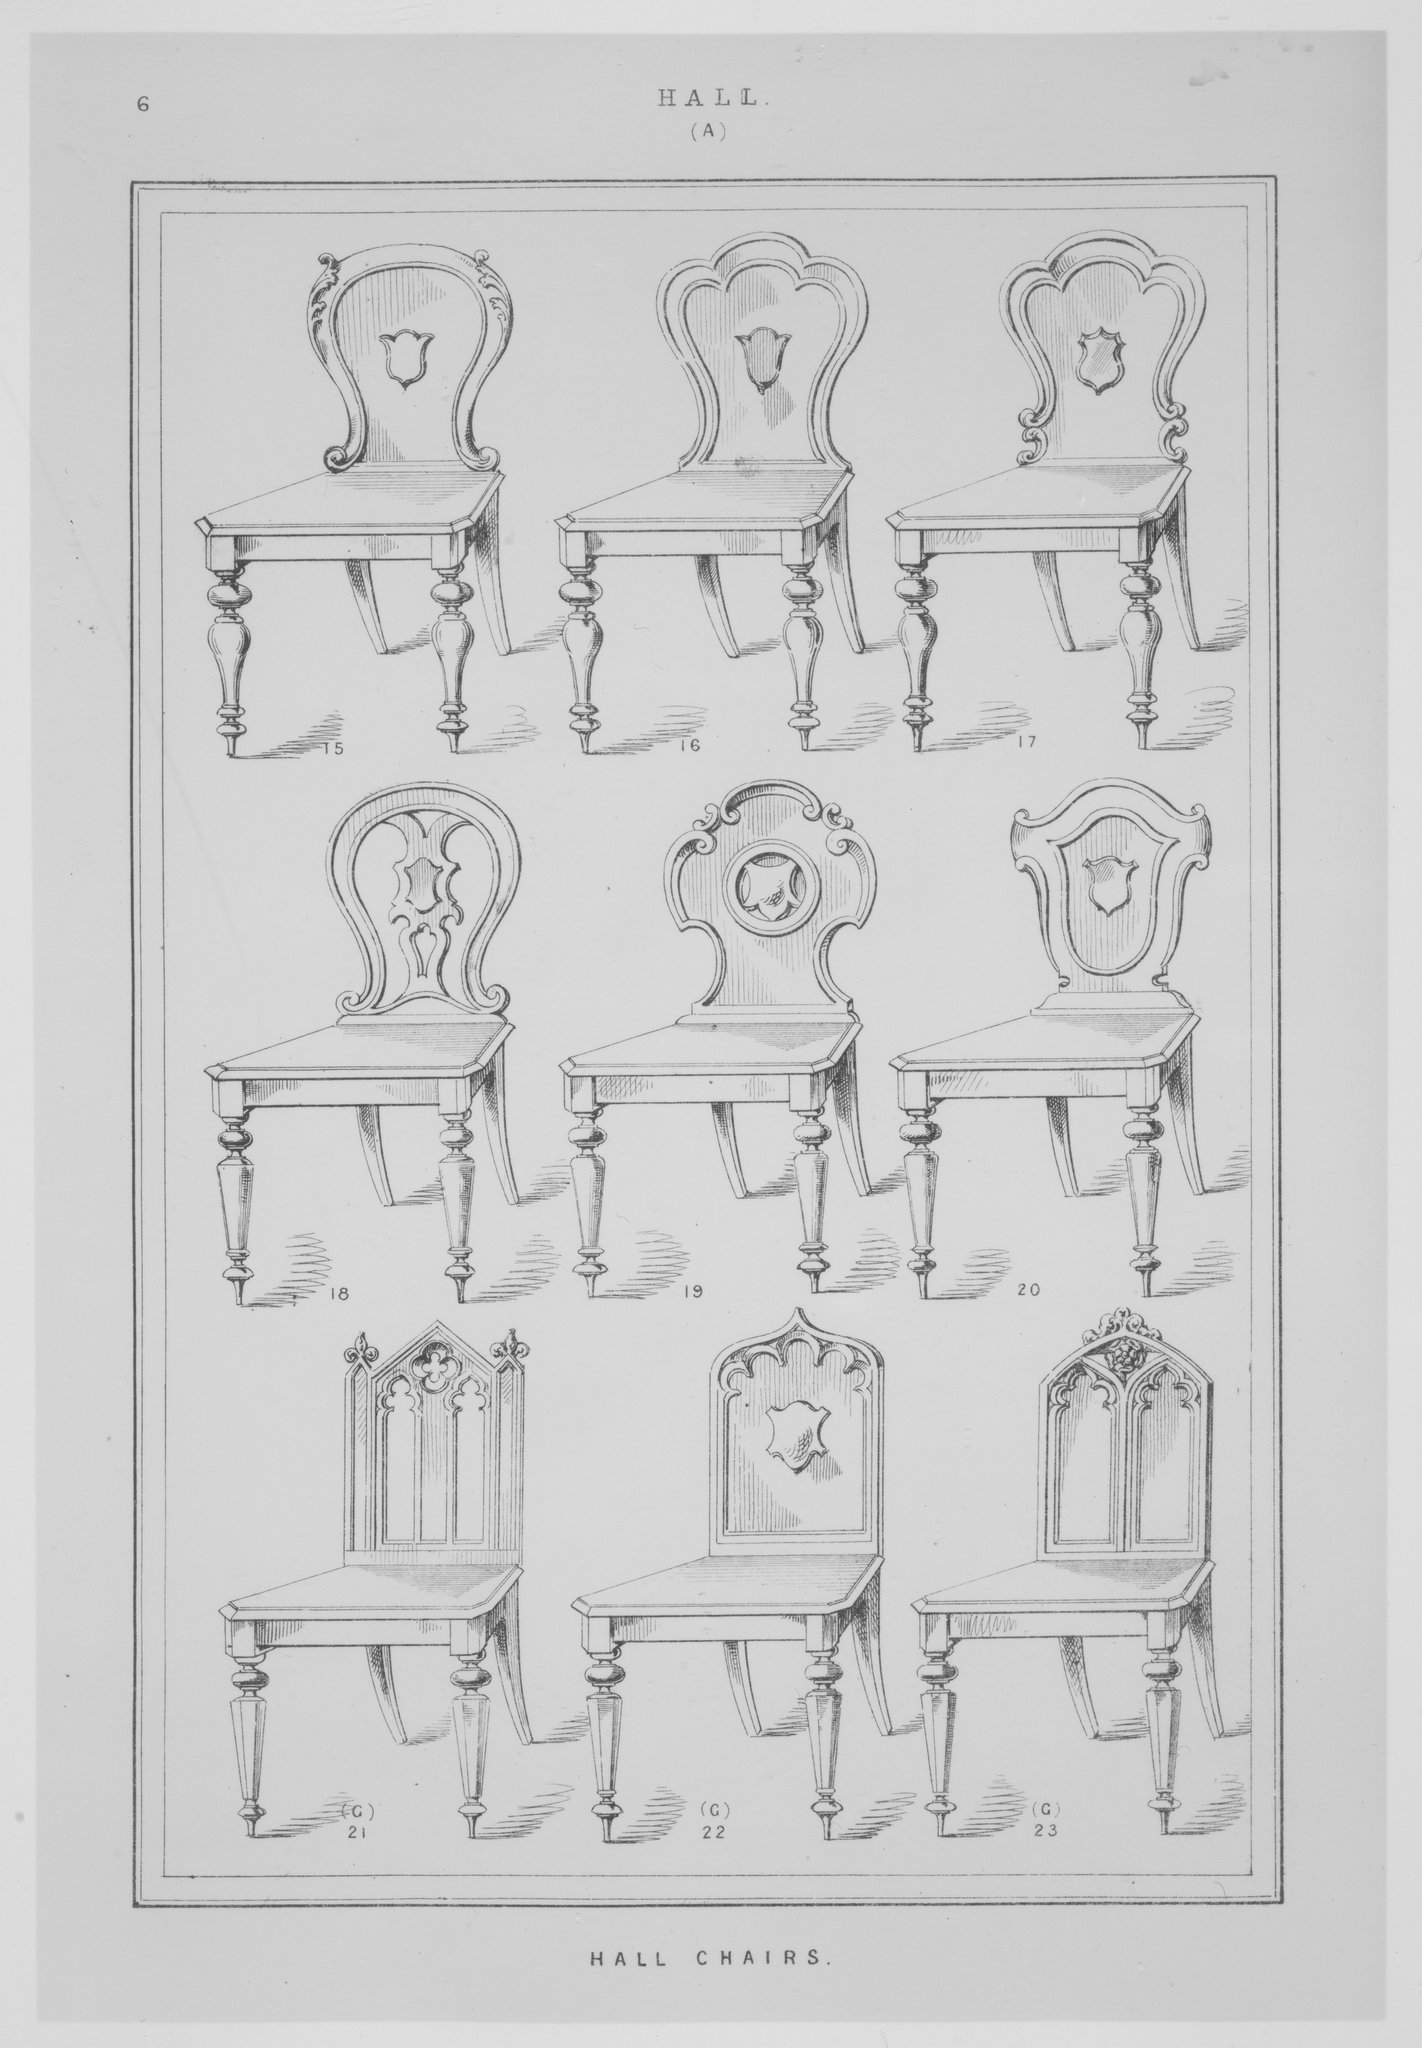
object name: book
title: Modern Furniture. Original and Select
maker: james lovegrove holt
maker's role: designer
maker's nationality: british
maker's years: 1750-1900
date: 1820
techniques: lithograph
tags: chairs